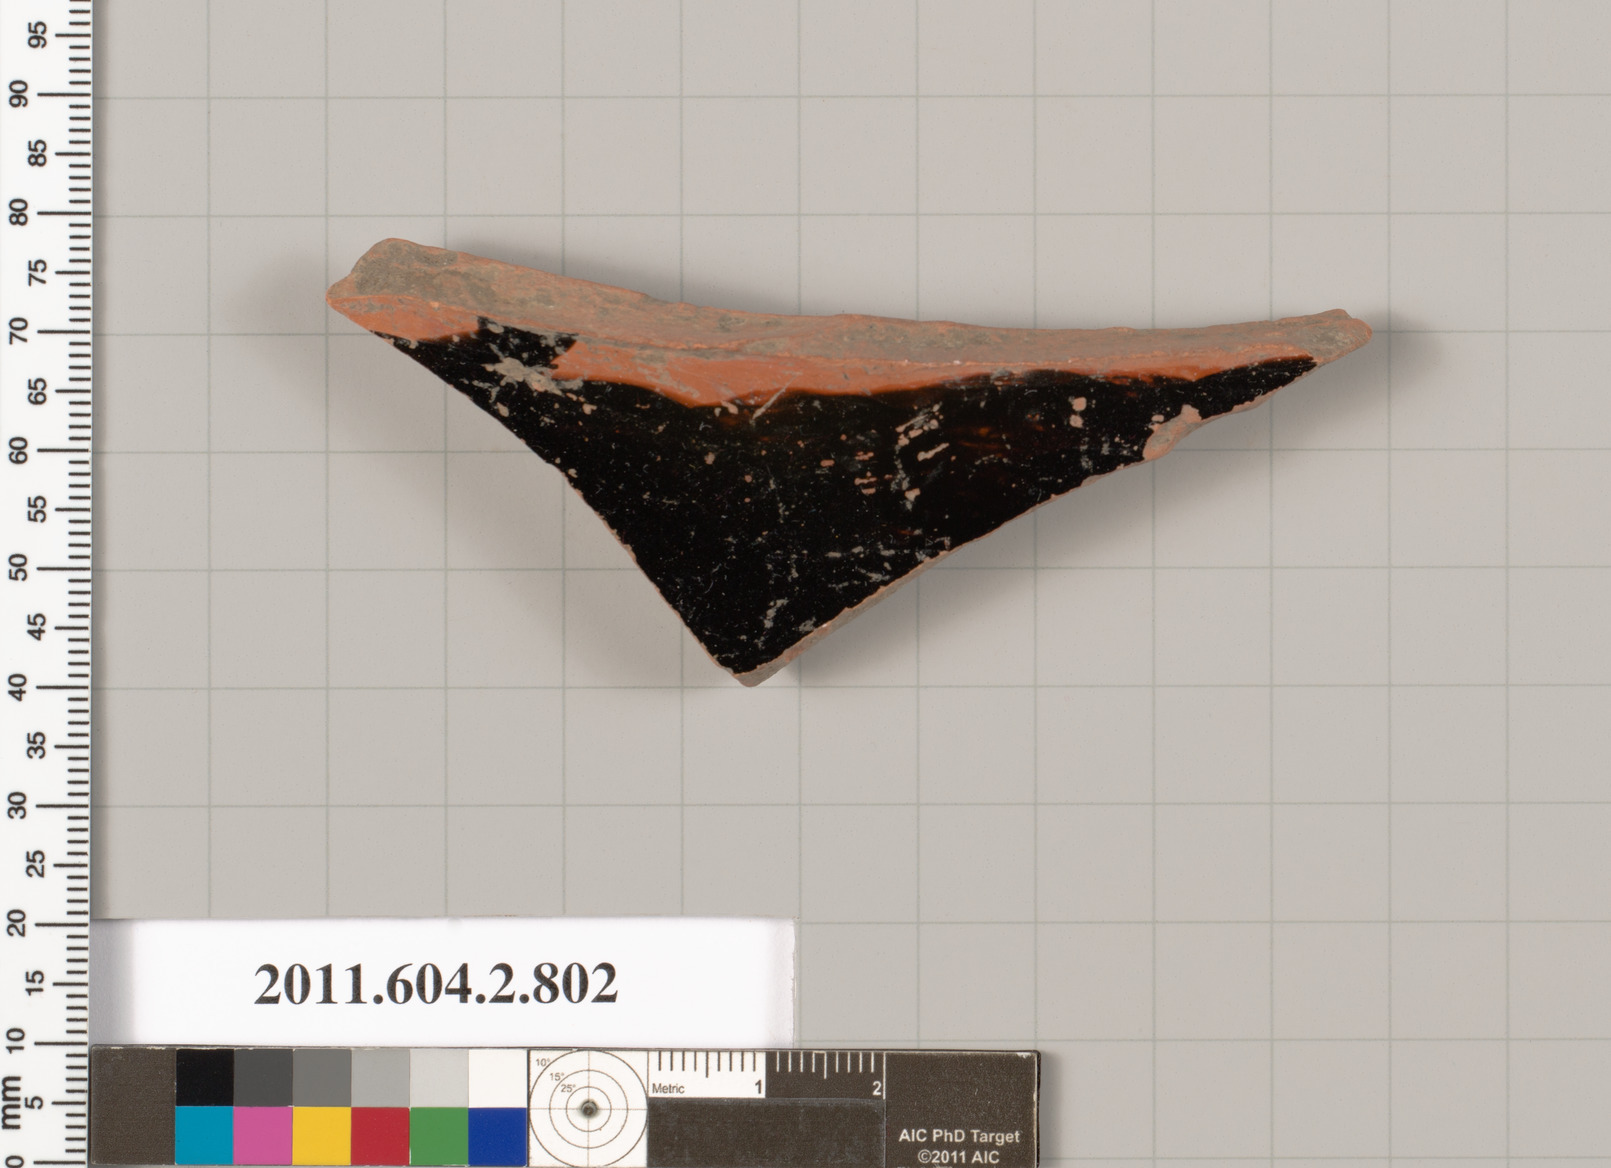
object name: calyx krater fragment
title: Terracotta fragment of a calyx-krater (bowl for mixing wine and water)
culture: greek, attic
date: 600-401 BCE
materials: terracotta